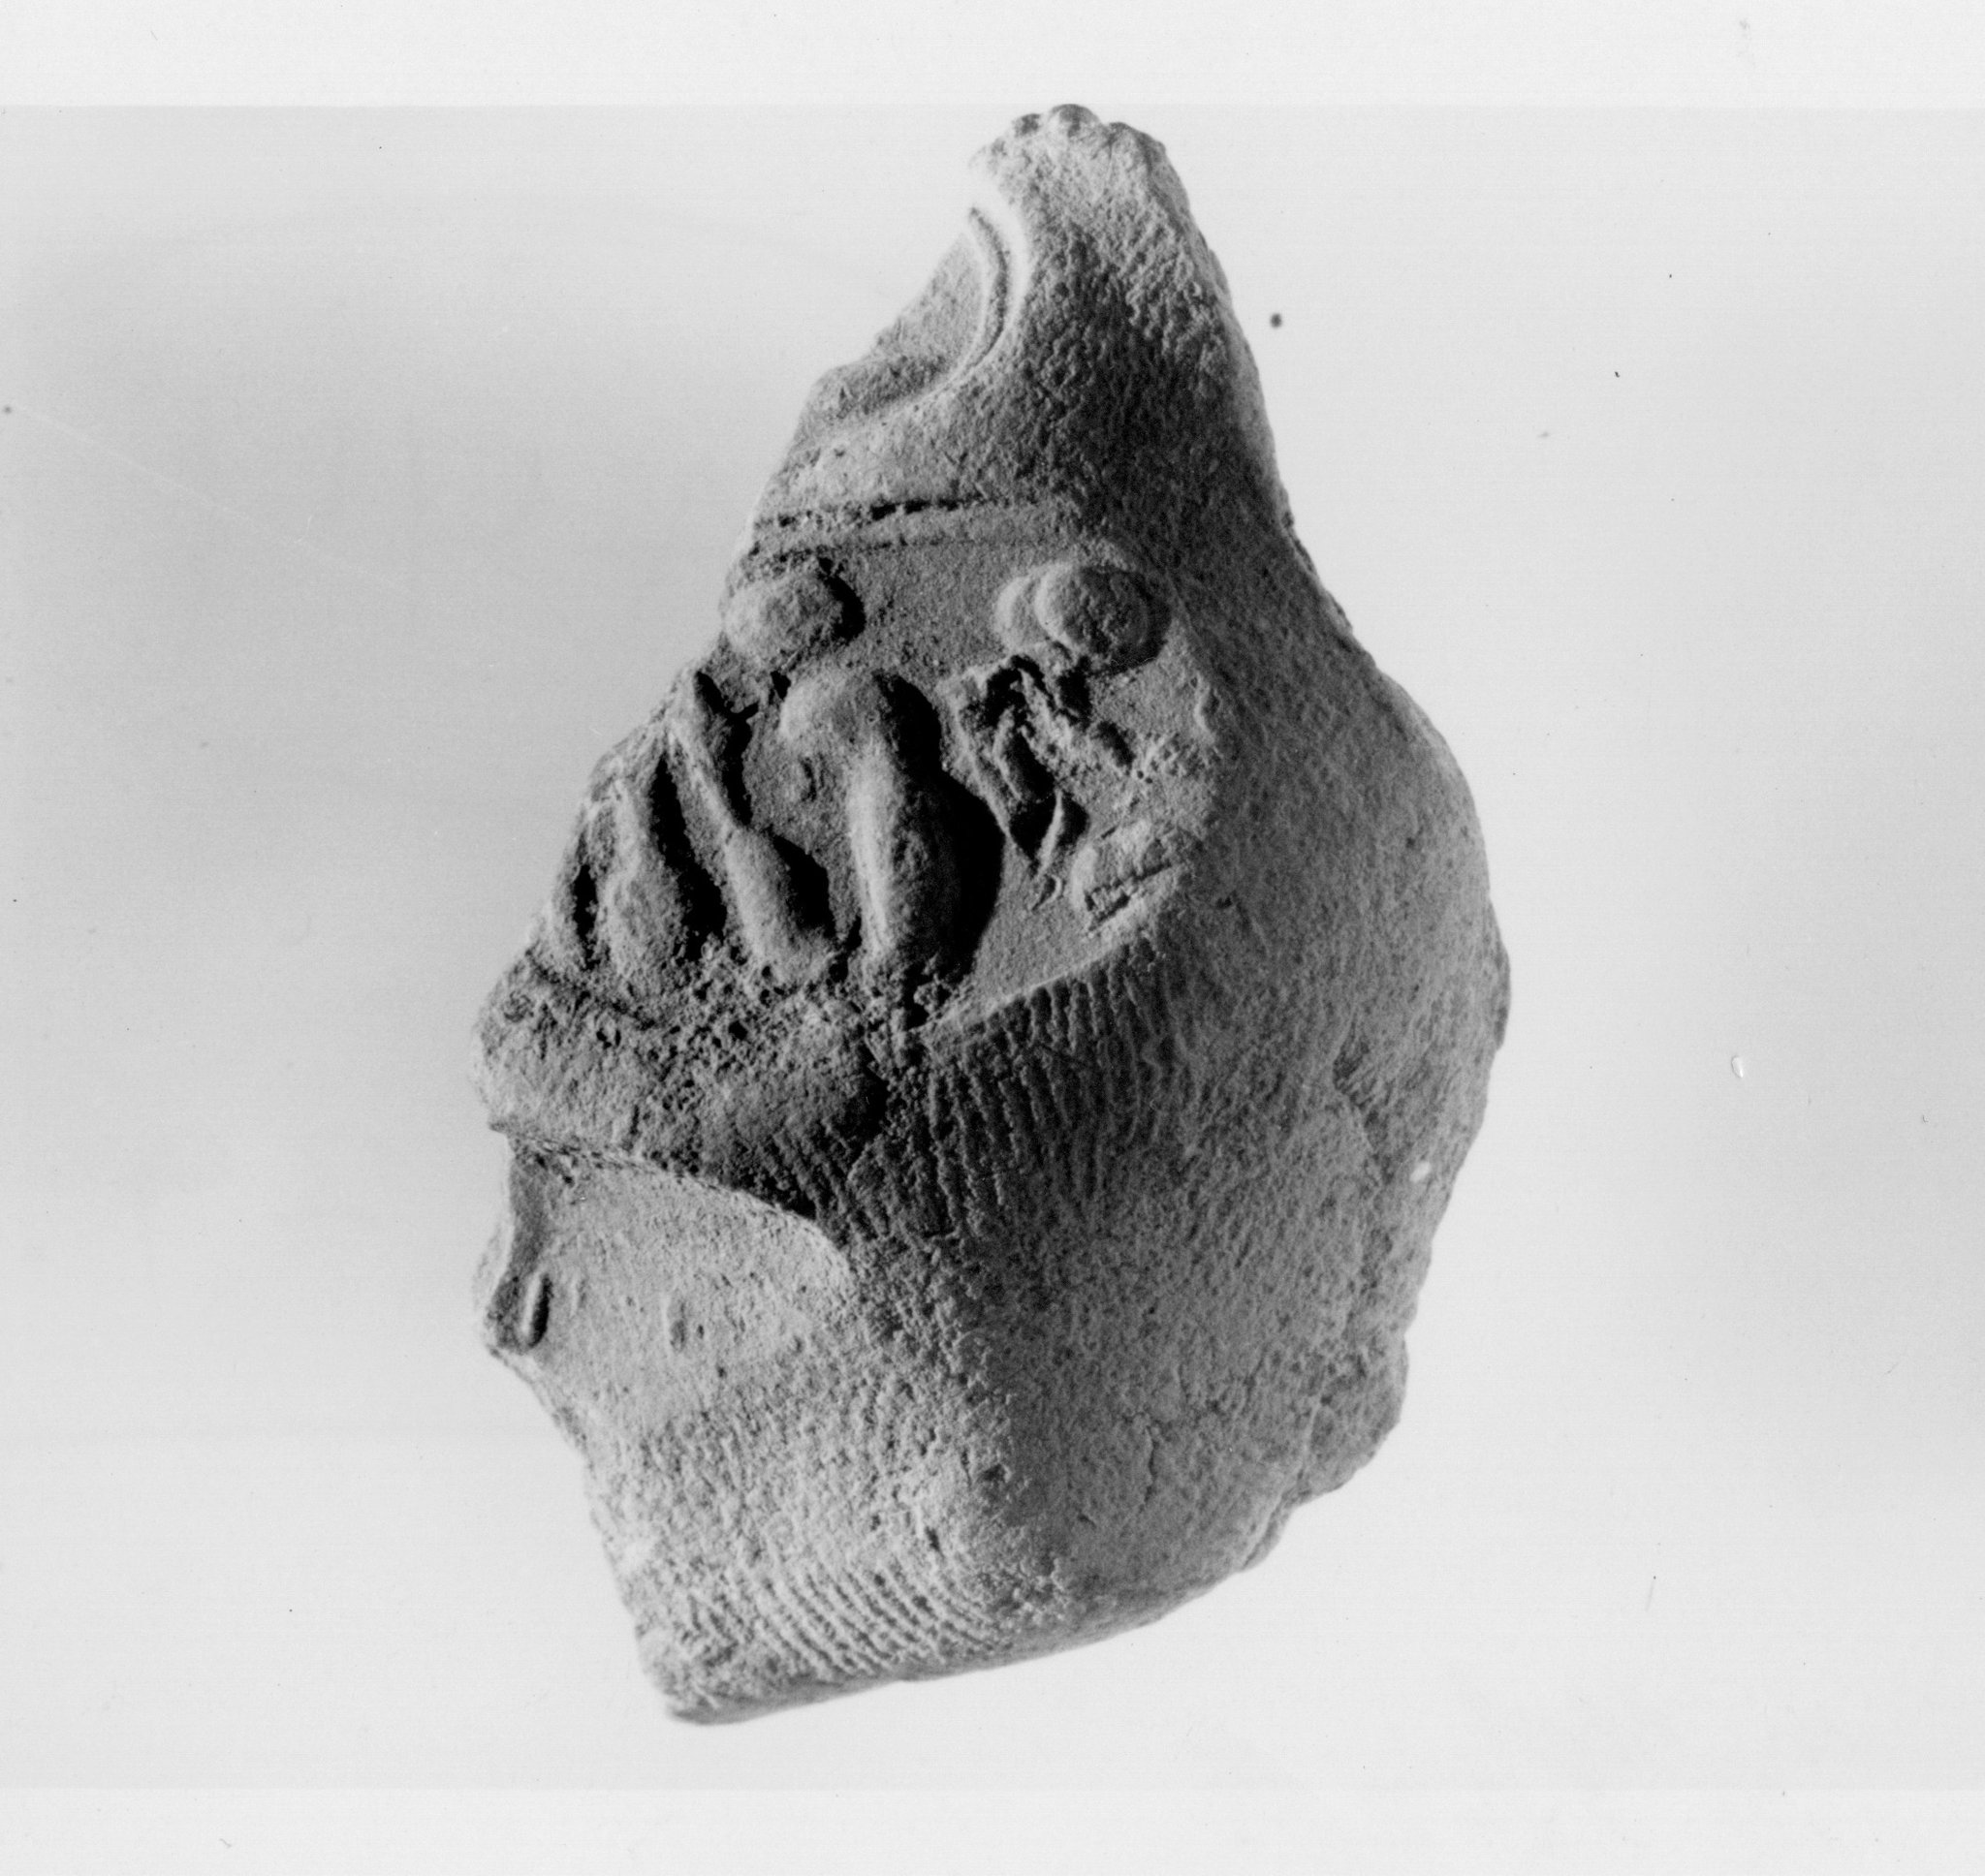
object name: sealing, nebmaatre, amenhotep iii,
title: Document Sealing With the Throne Name of Amenhotep III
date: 1390-1352 BCE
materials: mud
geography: egypt